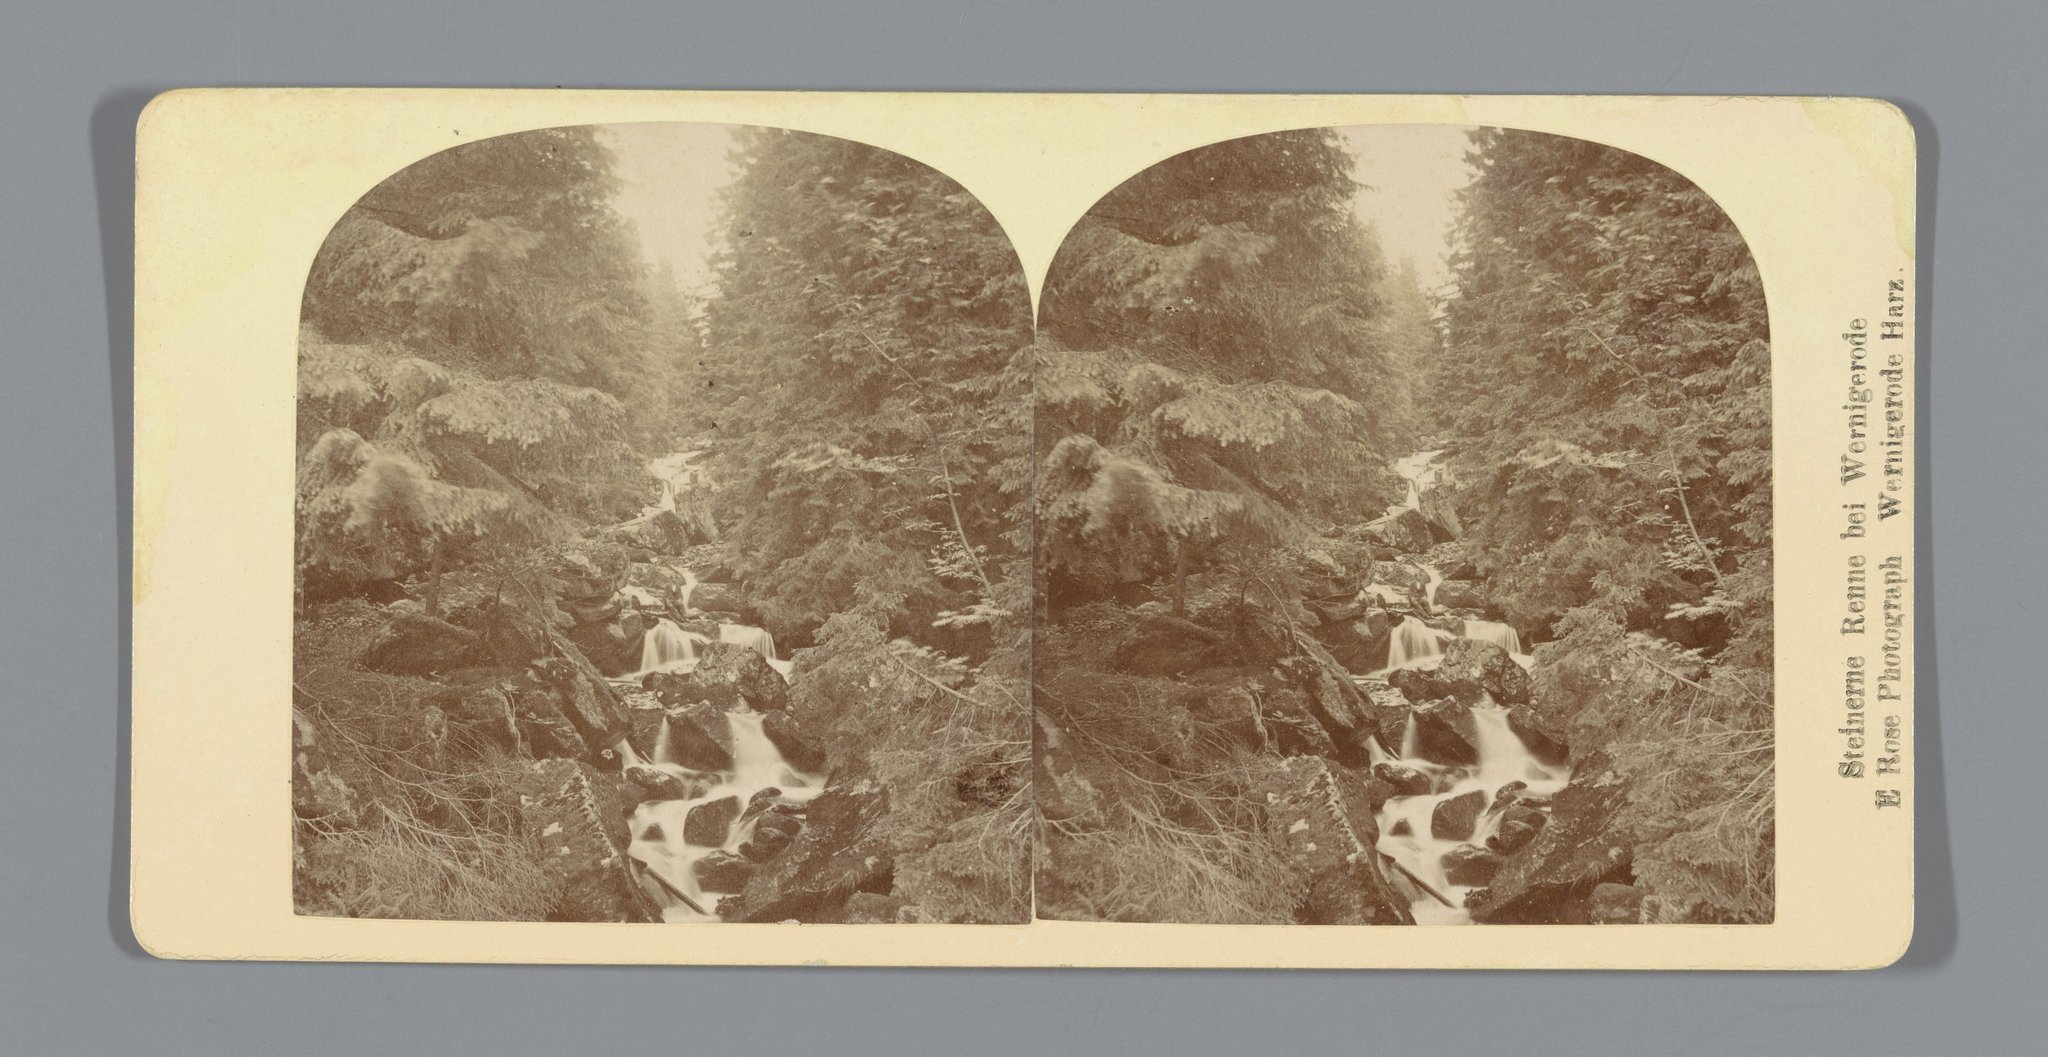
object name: stereograph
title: Steinerne Renne nabij Wernigerode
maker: e. rose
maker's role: fotograaf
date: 1855-1880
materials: cardboard, photographic support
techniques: albumen print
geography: harz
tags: brook